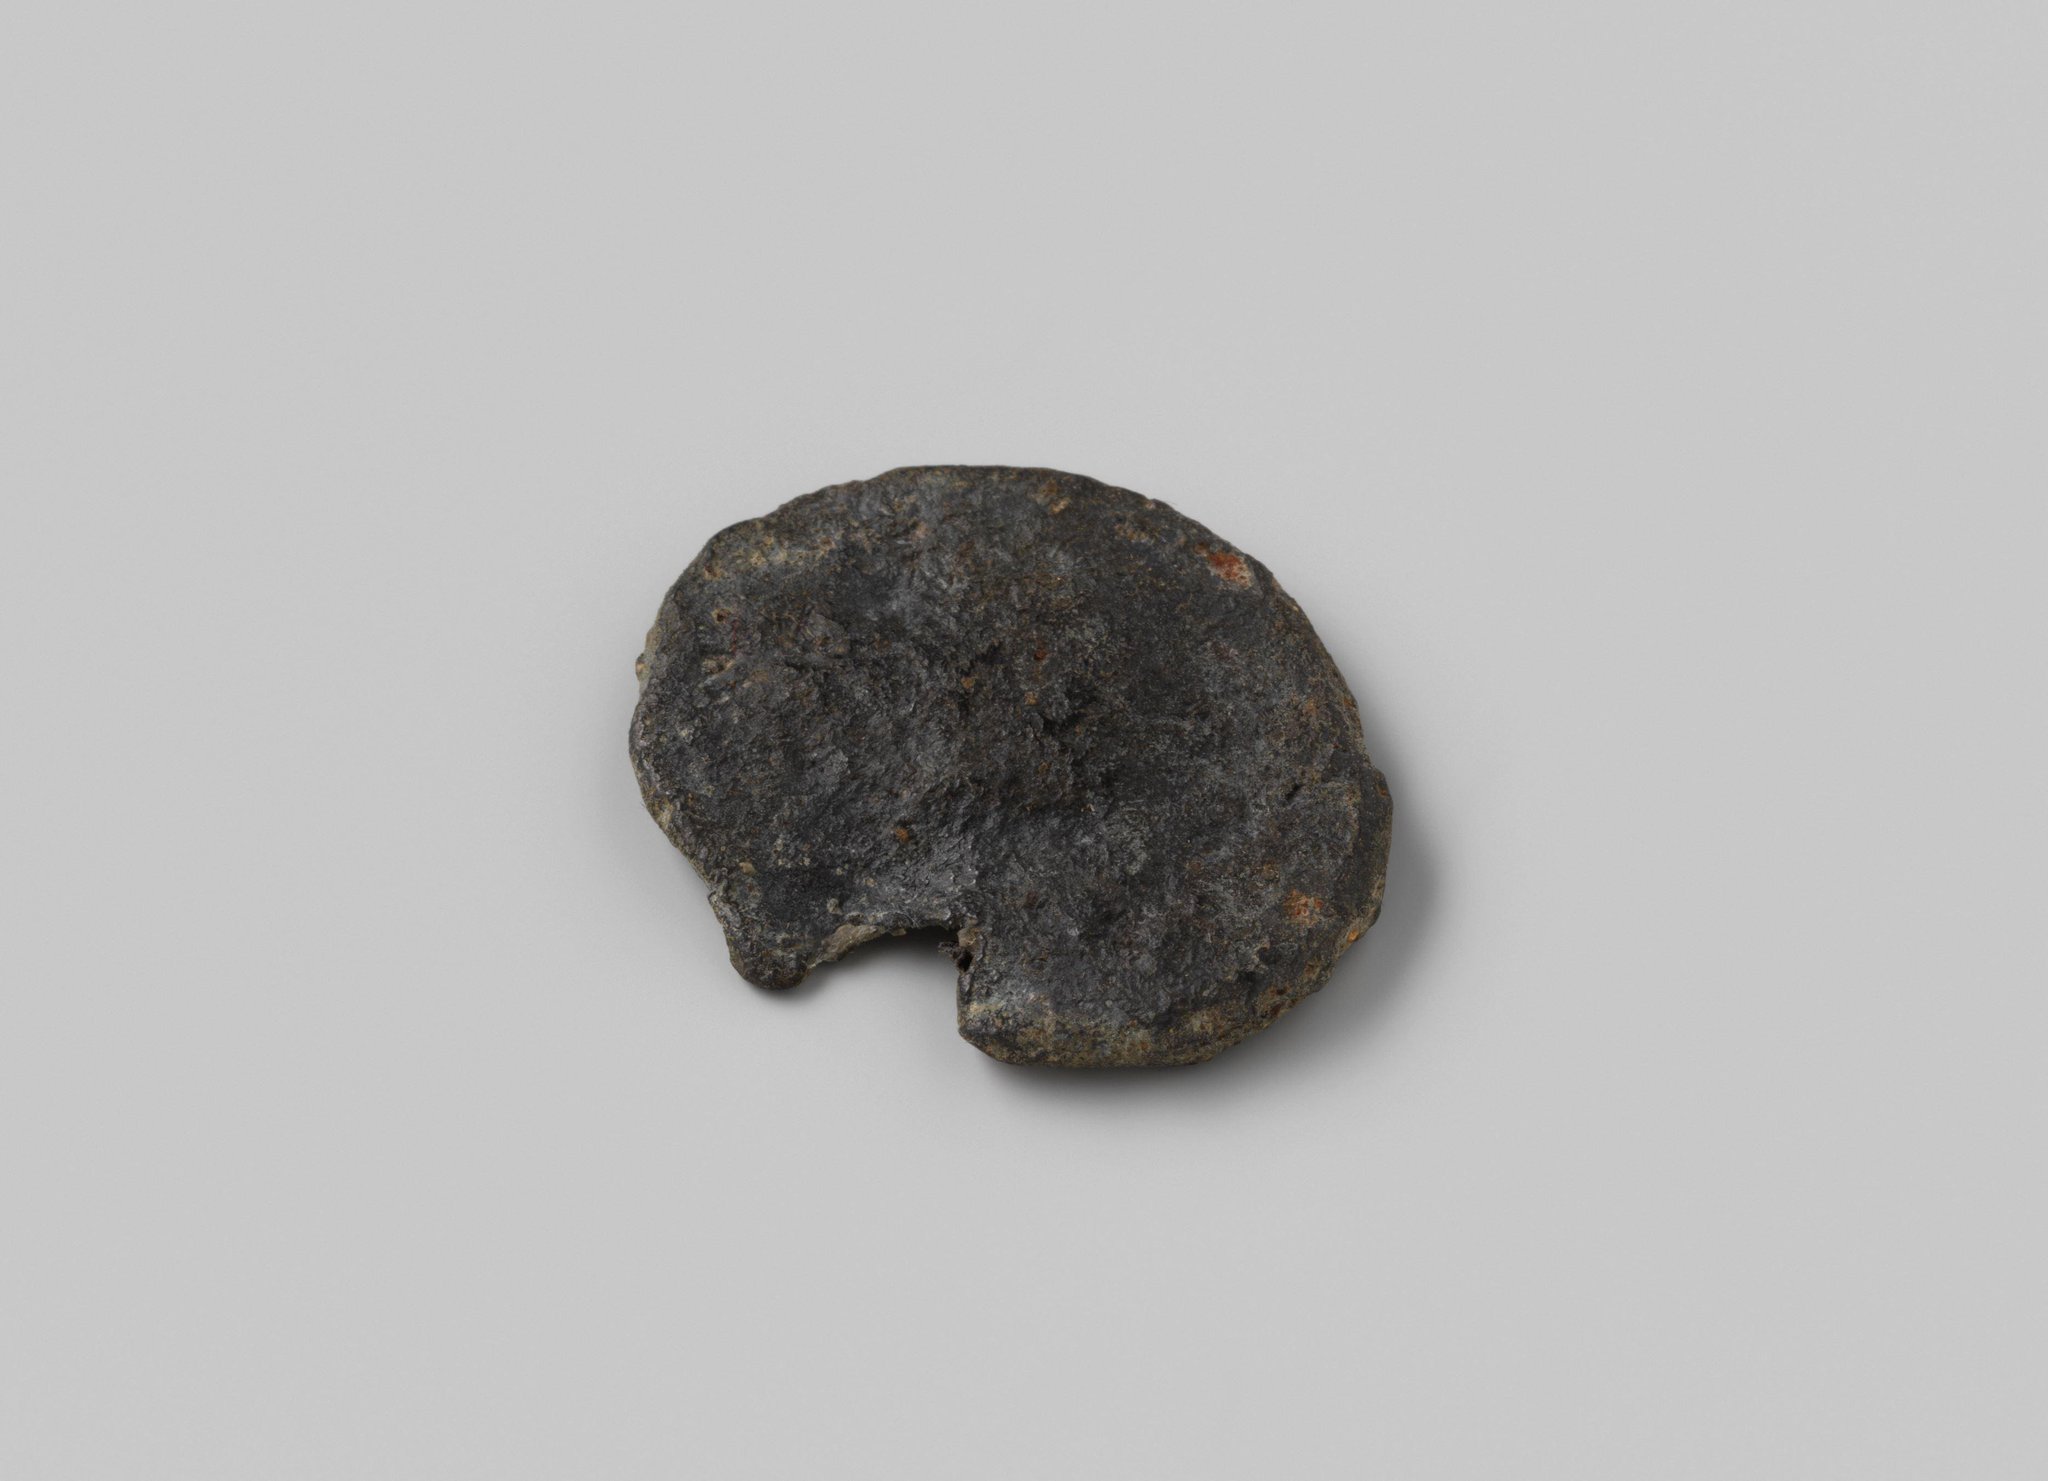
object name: fragment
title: Schijfvormig fragment uit het wrak van de Oost-Indiëvaarder Hollandia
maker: Anonymous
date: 1700-1743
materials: lead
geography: netherlands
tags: verenigde oostindische compagnie, hollandia (schip), annet